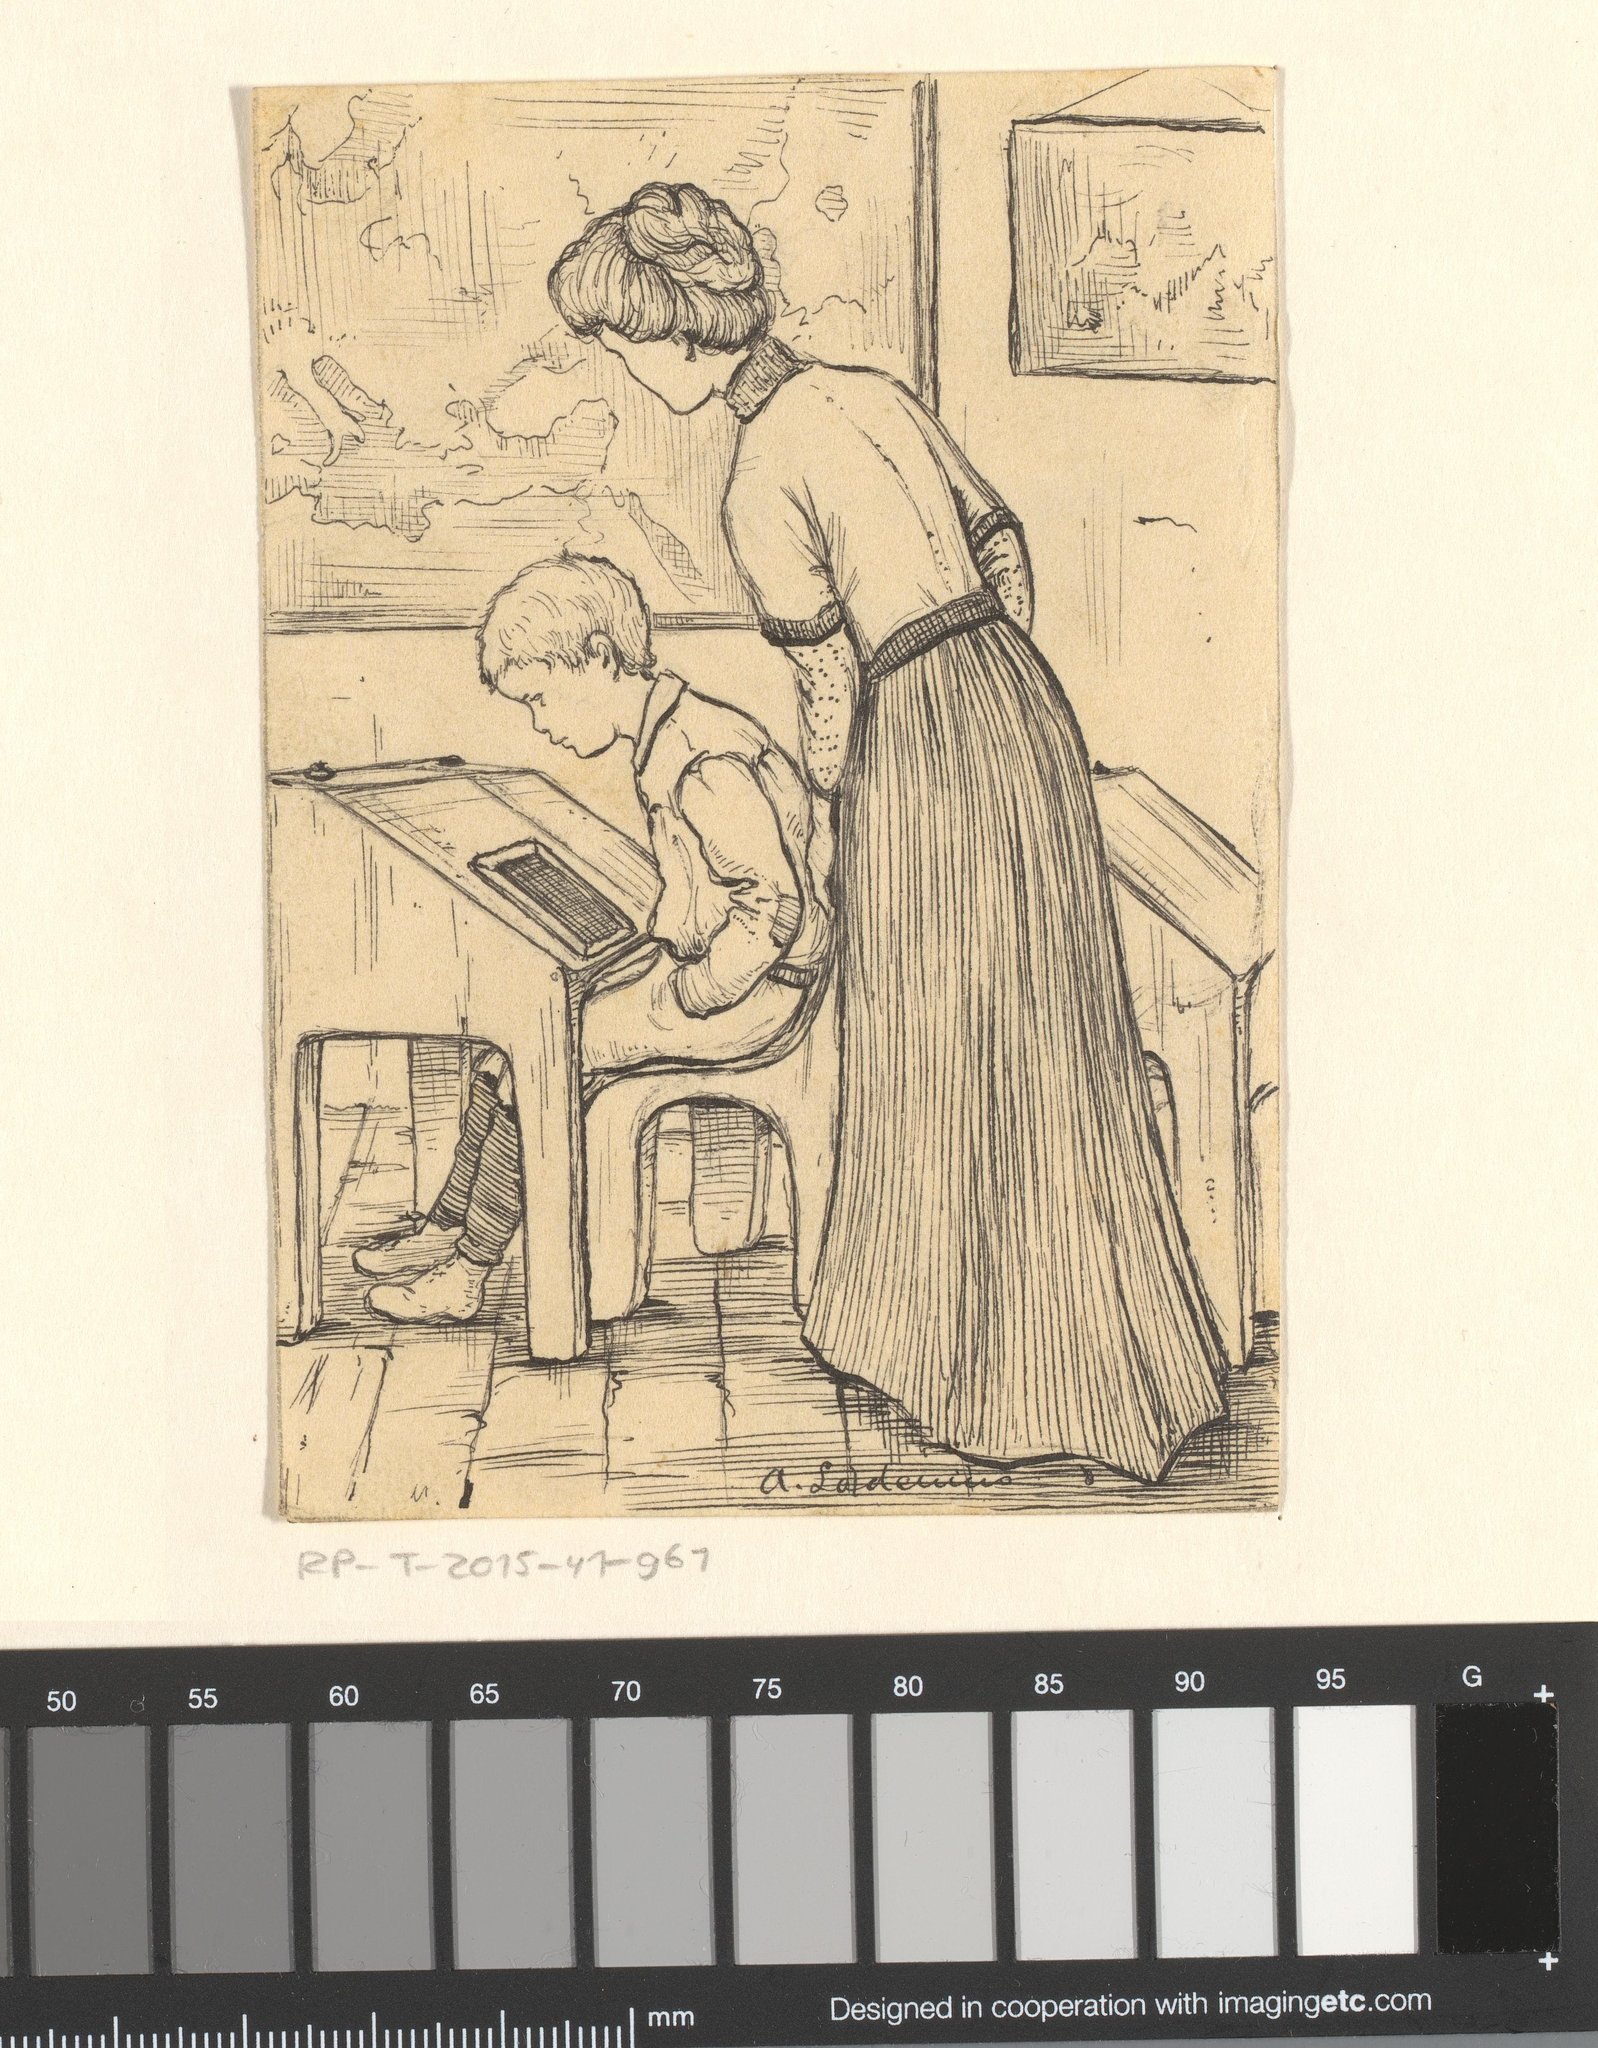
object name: boekillustratie ontwerp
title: Jongen met een lei aan een lessenaar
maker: adri ladenius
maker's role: draughtsman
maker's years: 1883-1953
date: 1893-1953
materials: ink, paper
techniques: pen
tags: slate (writing material), teacher and pupil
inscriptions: annotation: ‘Kees [...]s/ Aus[...]rt/ II’, signature: ‘A. Ladenius’, :, collector's mark: Lugt 2228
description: In een klaslokaal zit een jongen aan een lessenaar. Hij buigt zich over een lei die voor hem ligt. Een juffrouw kijkt over zijn schouder met hem mee.